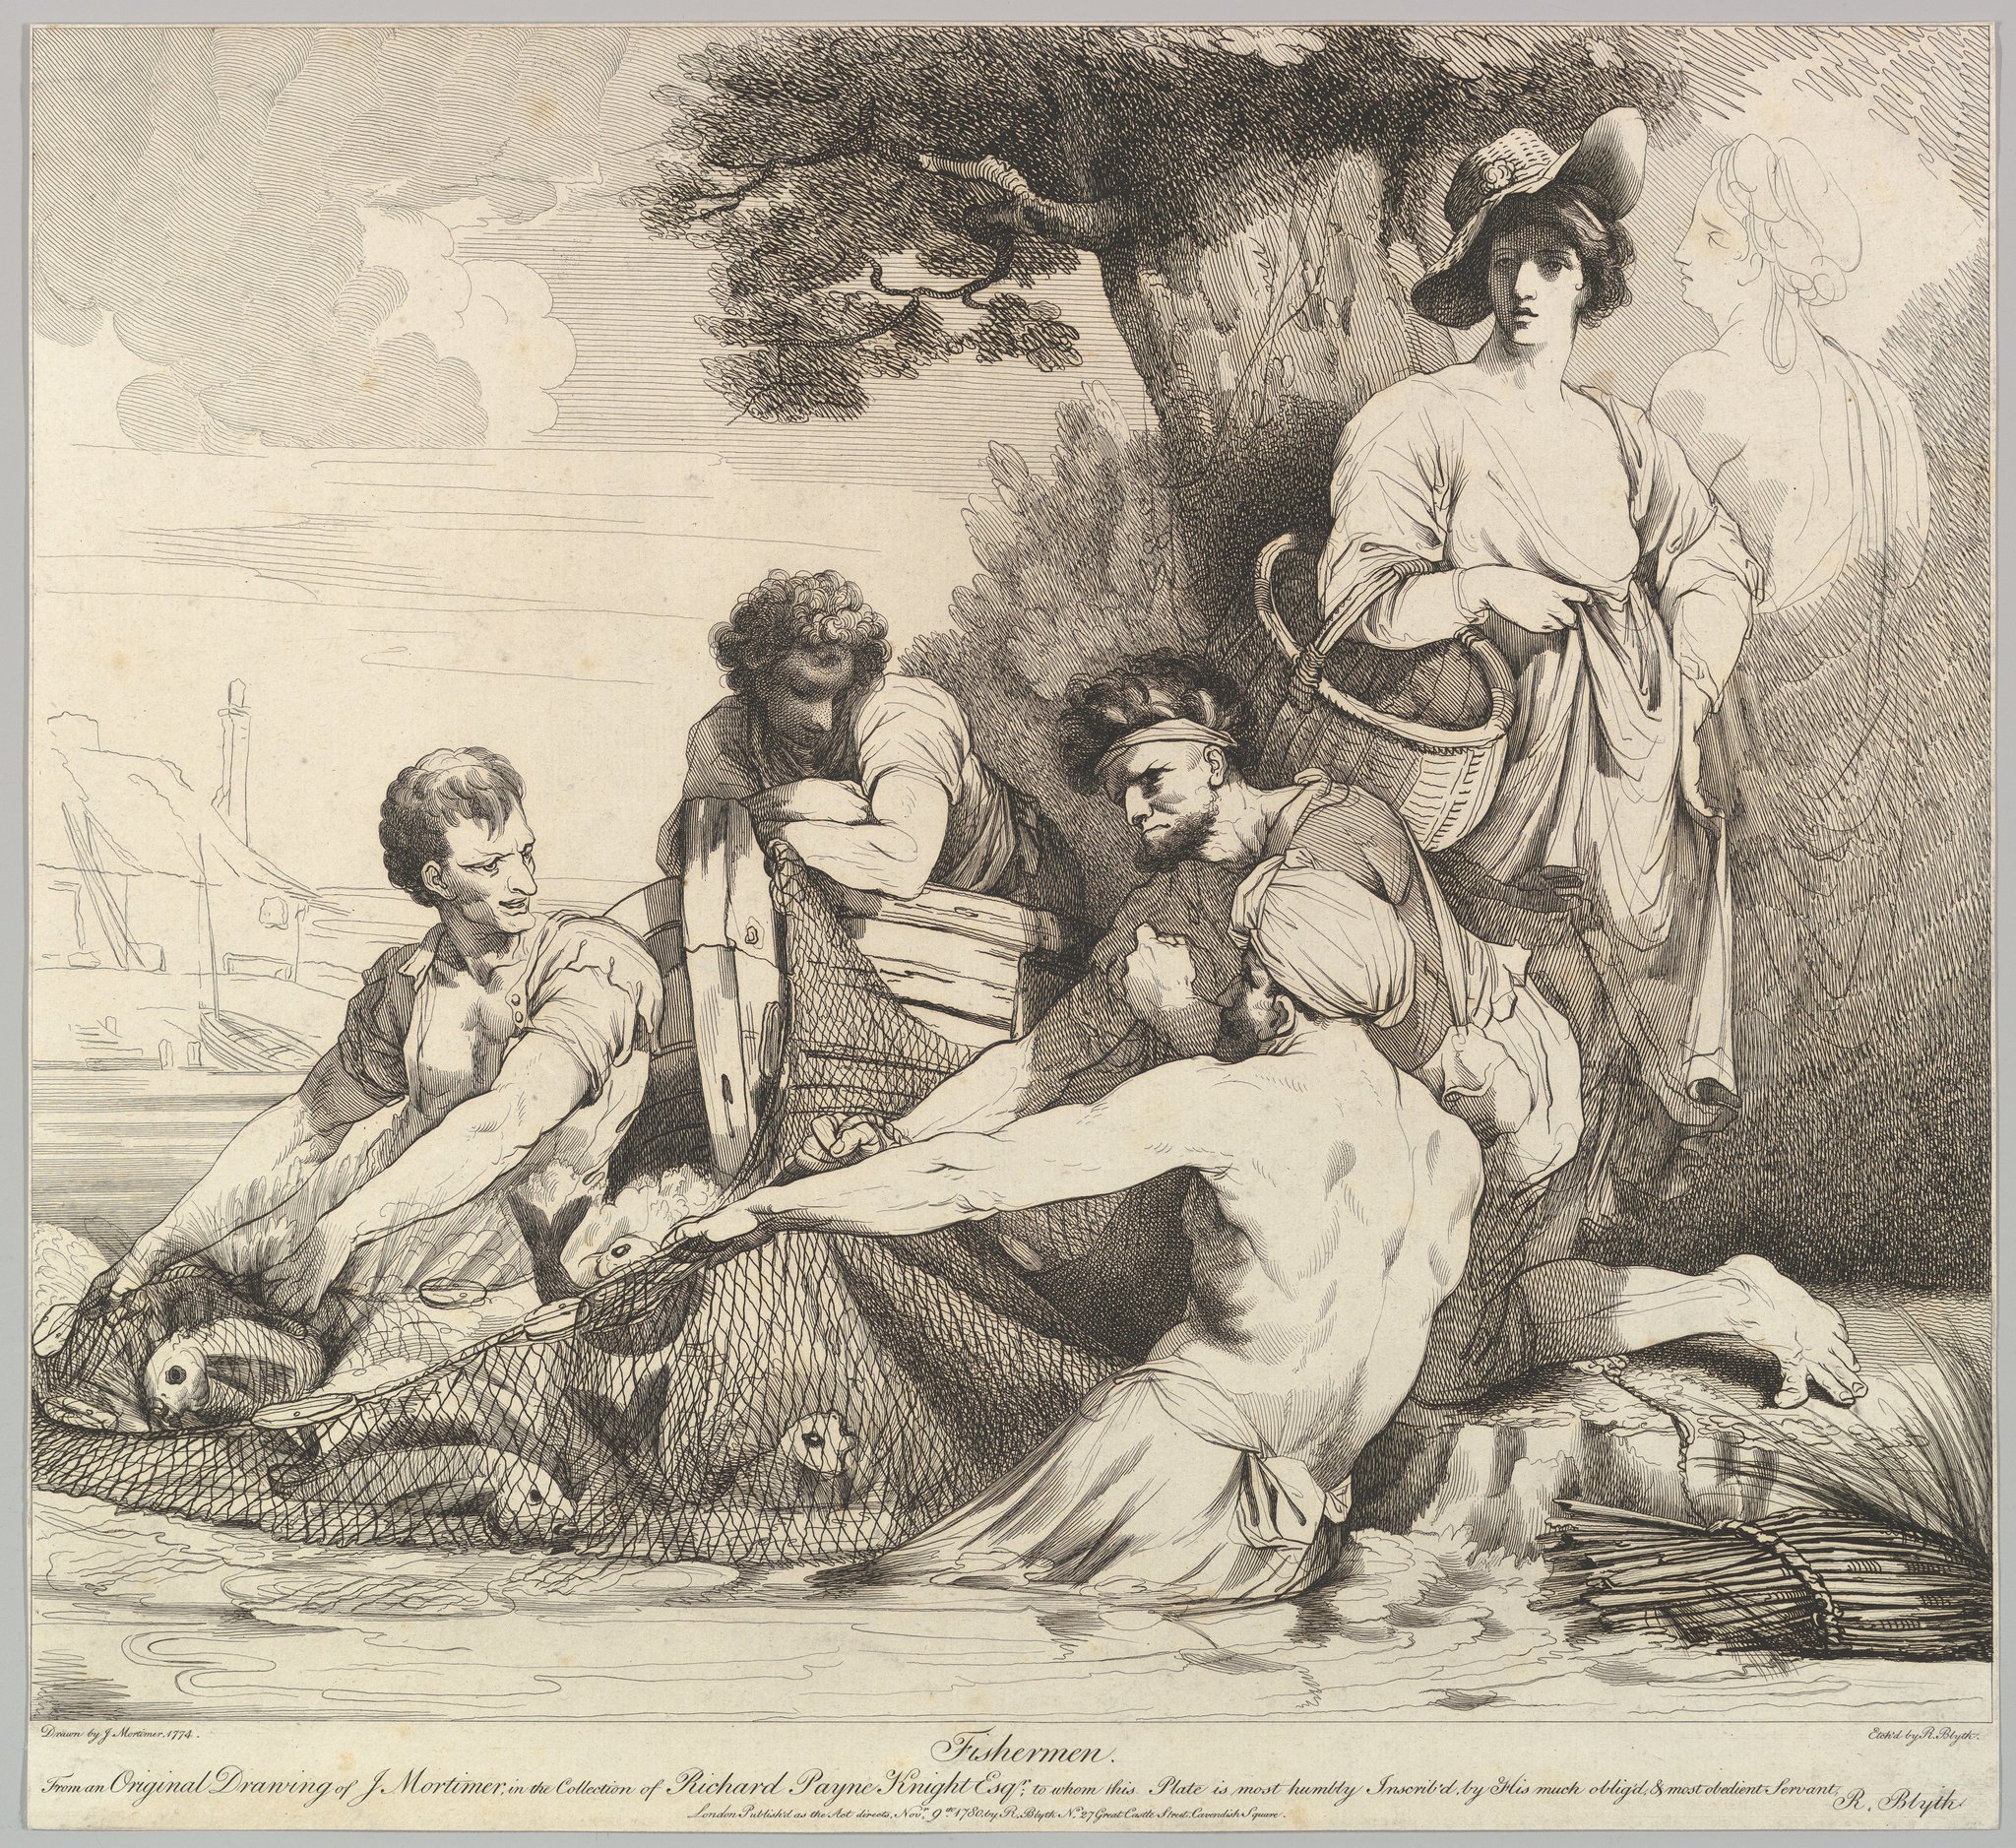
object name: print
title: Fishermen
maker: robert blyth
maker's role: artist and publisher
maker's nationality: british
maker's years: 1750-1784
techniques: etching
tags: men,women,fishing,fish,working